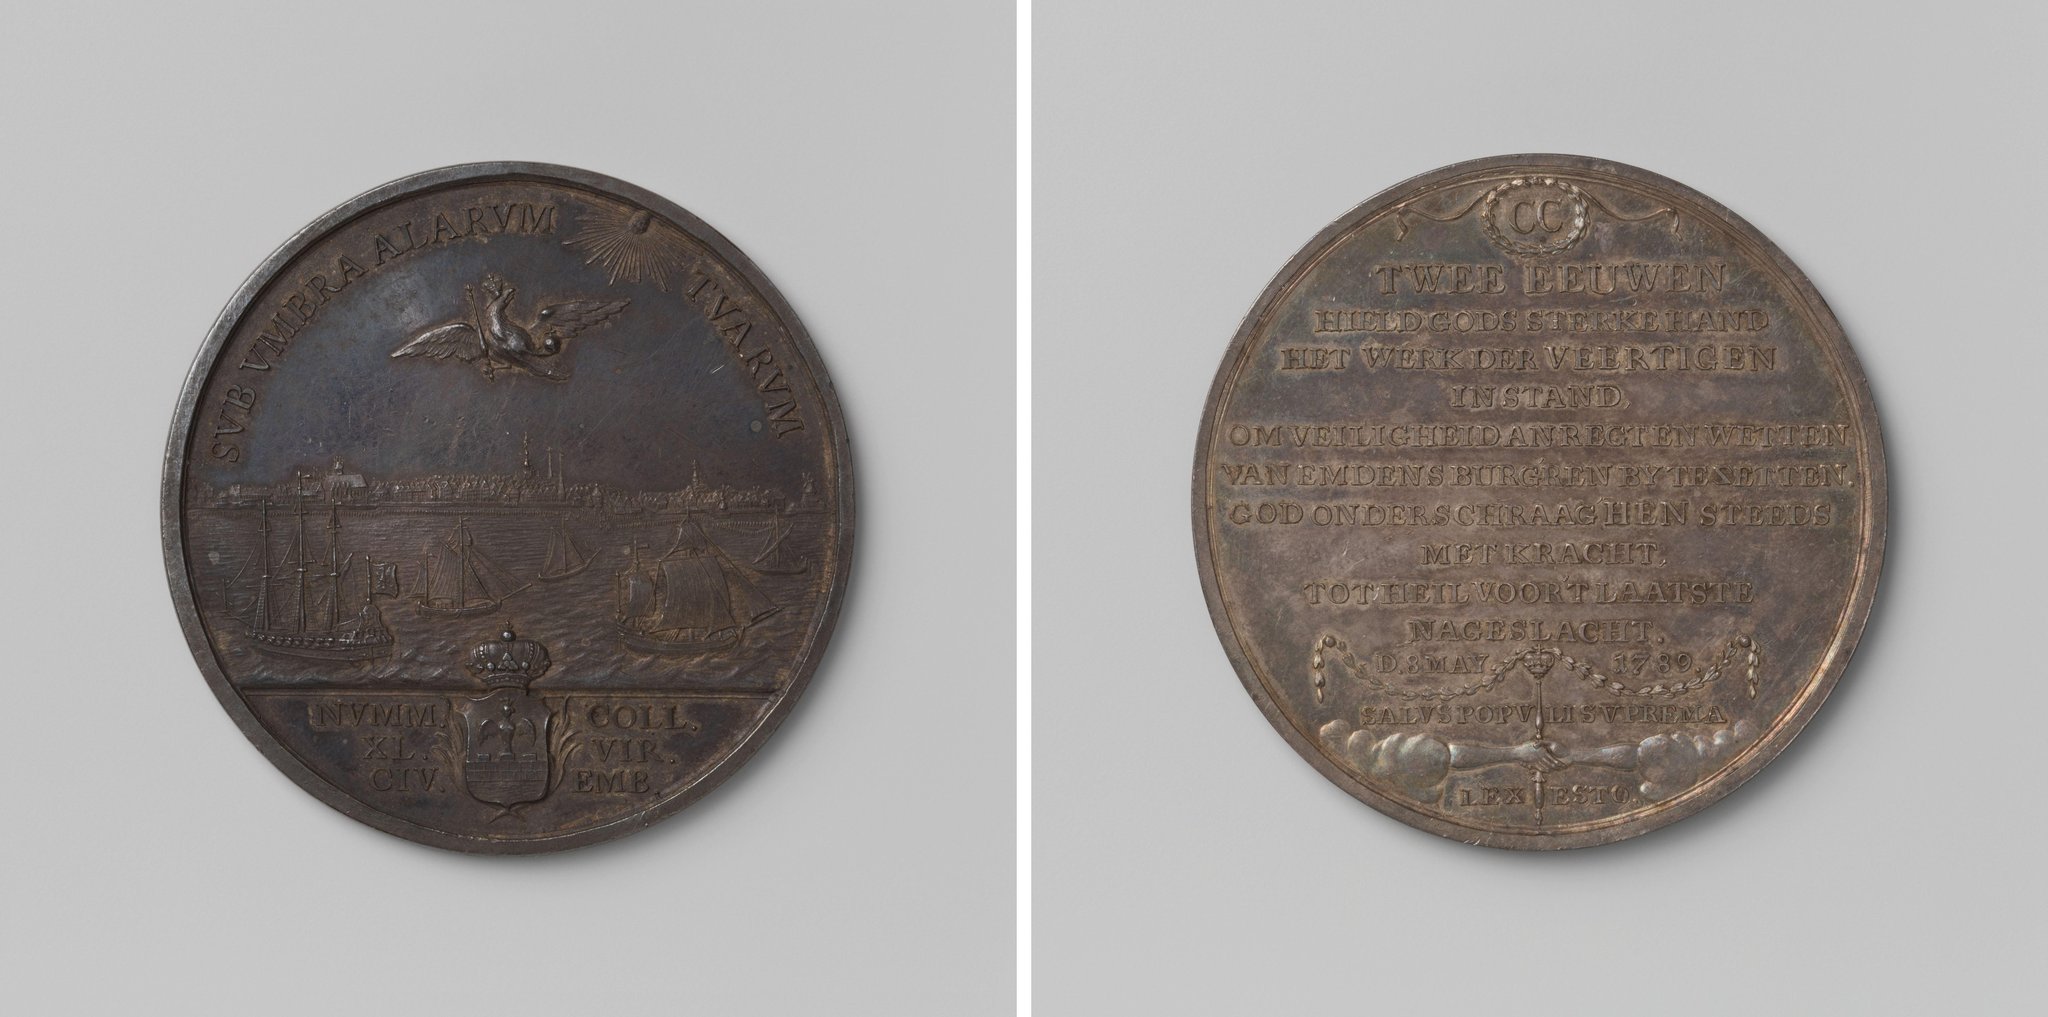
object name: council medal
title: Stad Embden, vroedschapspenning ter ere van het tweede eeuwfeest van het bestaan van het college van veertig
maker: Anonymous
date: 1789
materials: silver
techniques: striking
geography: emden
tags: emden